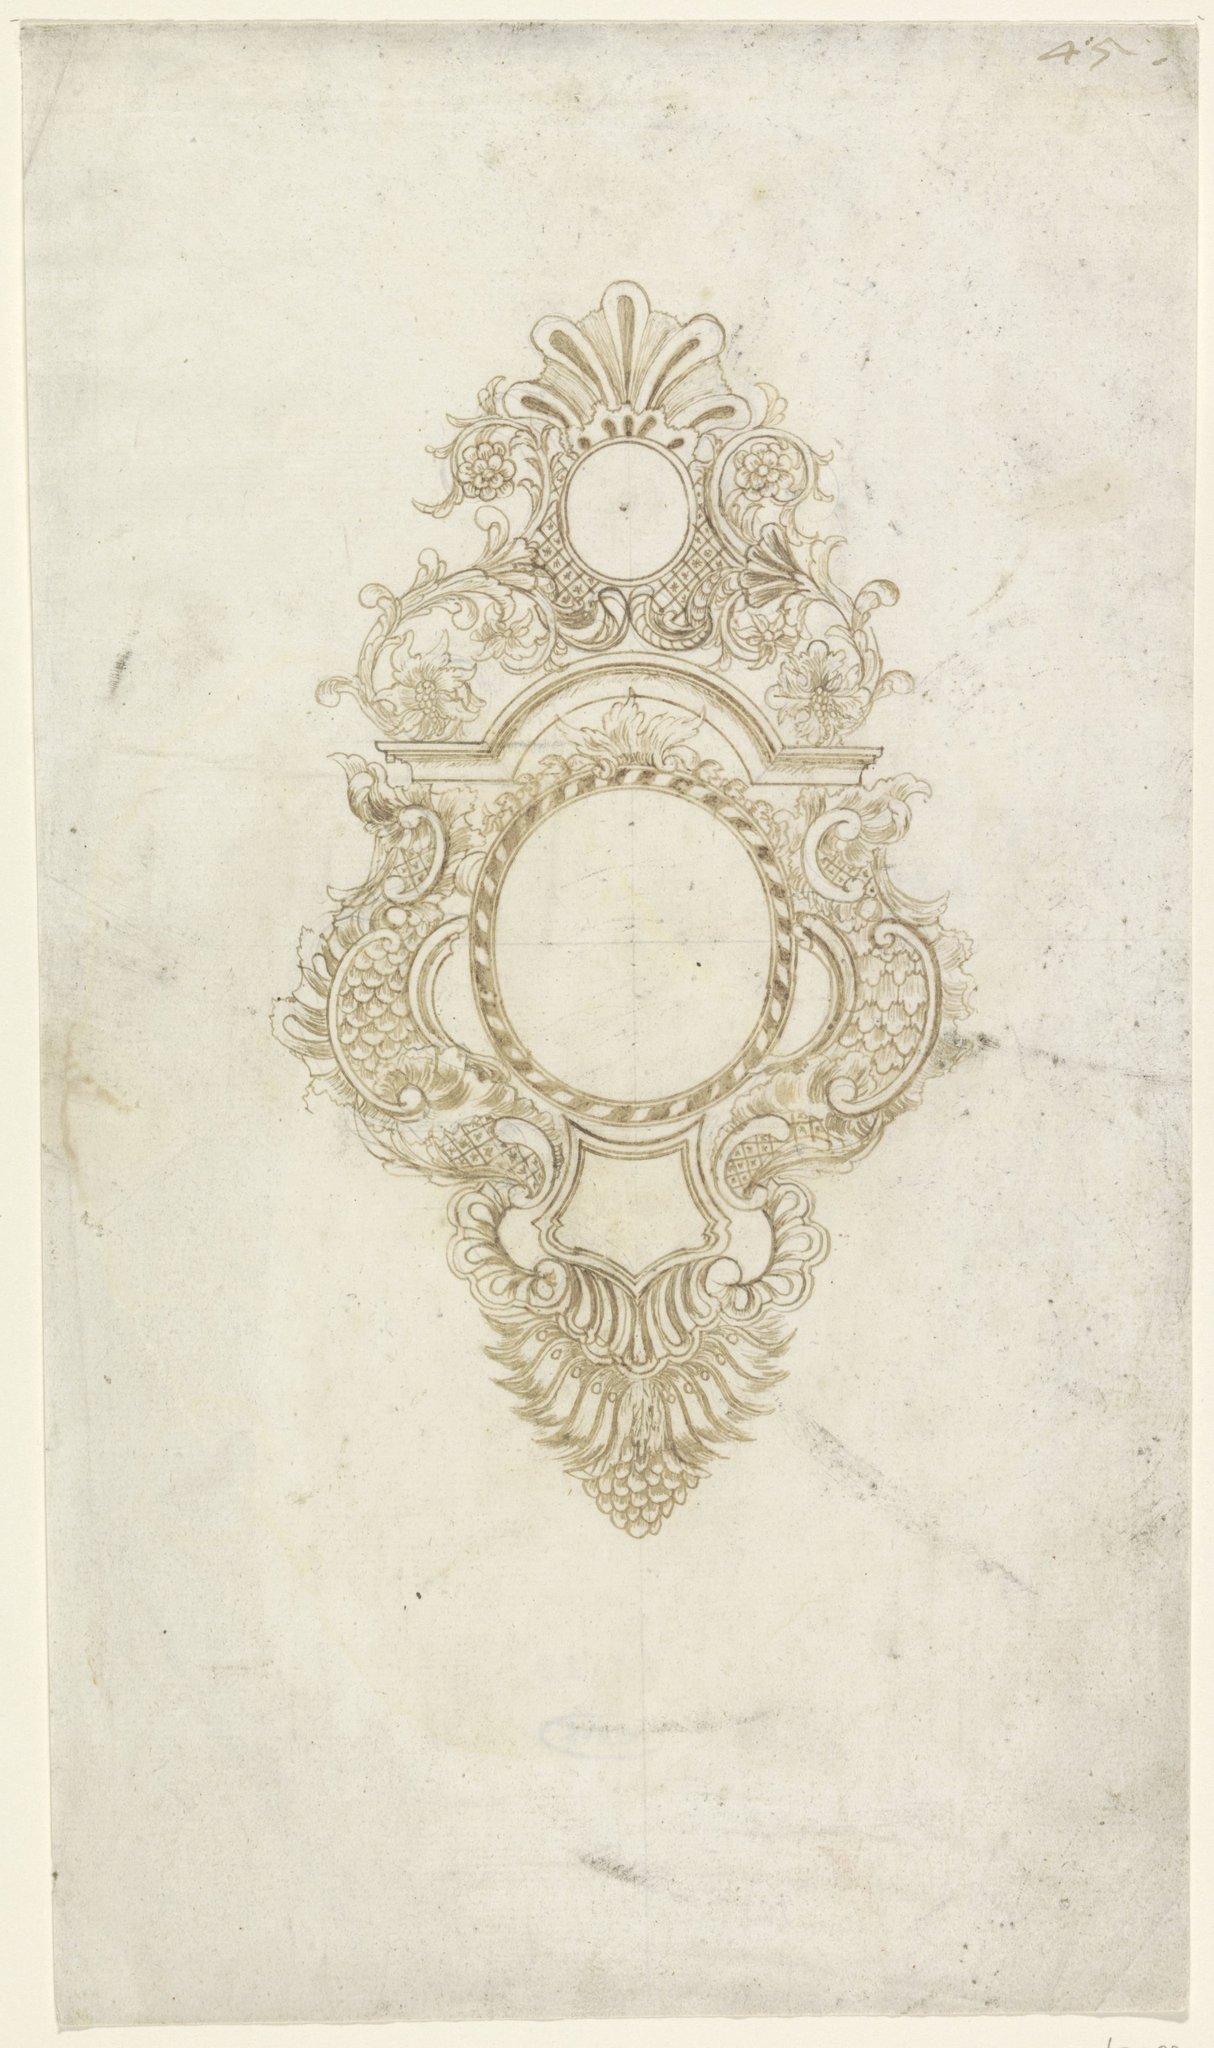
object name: ornamenttekening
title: Medaillon met bloemmotieven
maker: Anonymous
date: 1725-1750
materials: ink, paper, pencil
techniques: pen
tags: ornament ~ medallion, flowers ~ ornament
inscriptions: collector's mark: Lugt 2228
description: Een ovaal medaillon met bijwerk van rocailles en bloemmotieven.